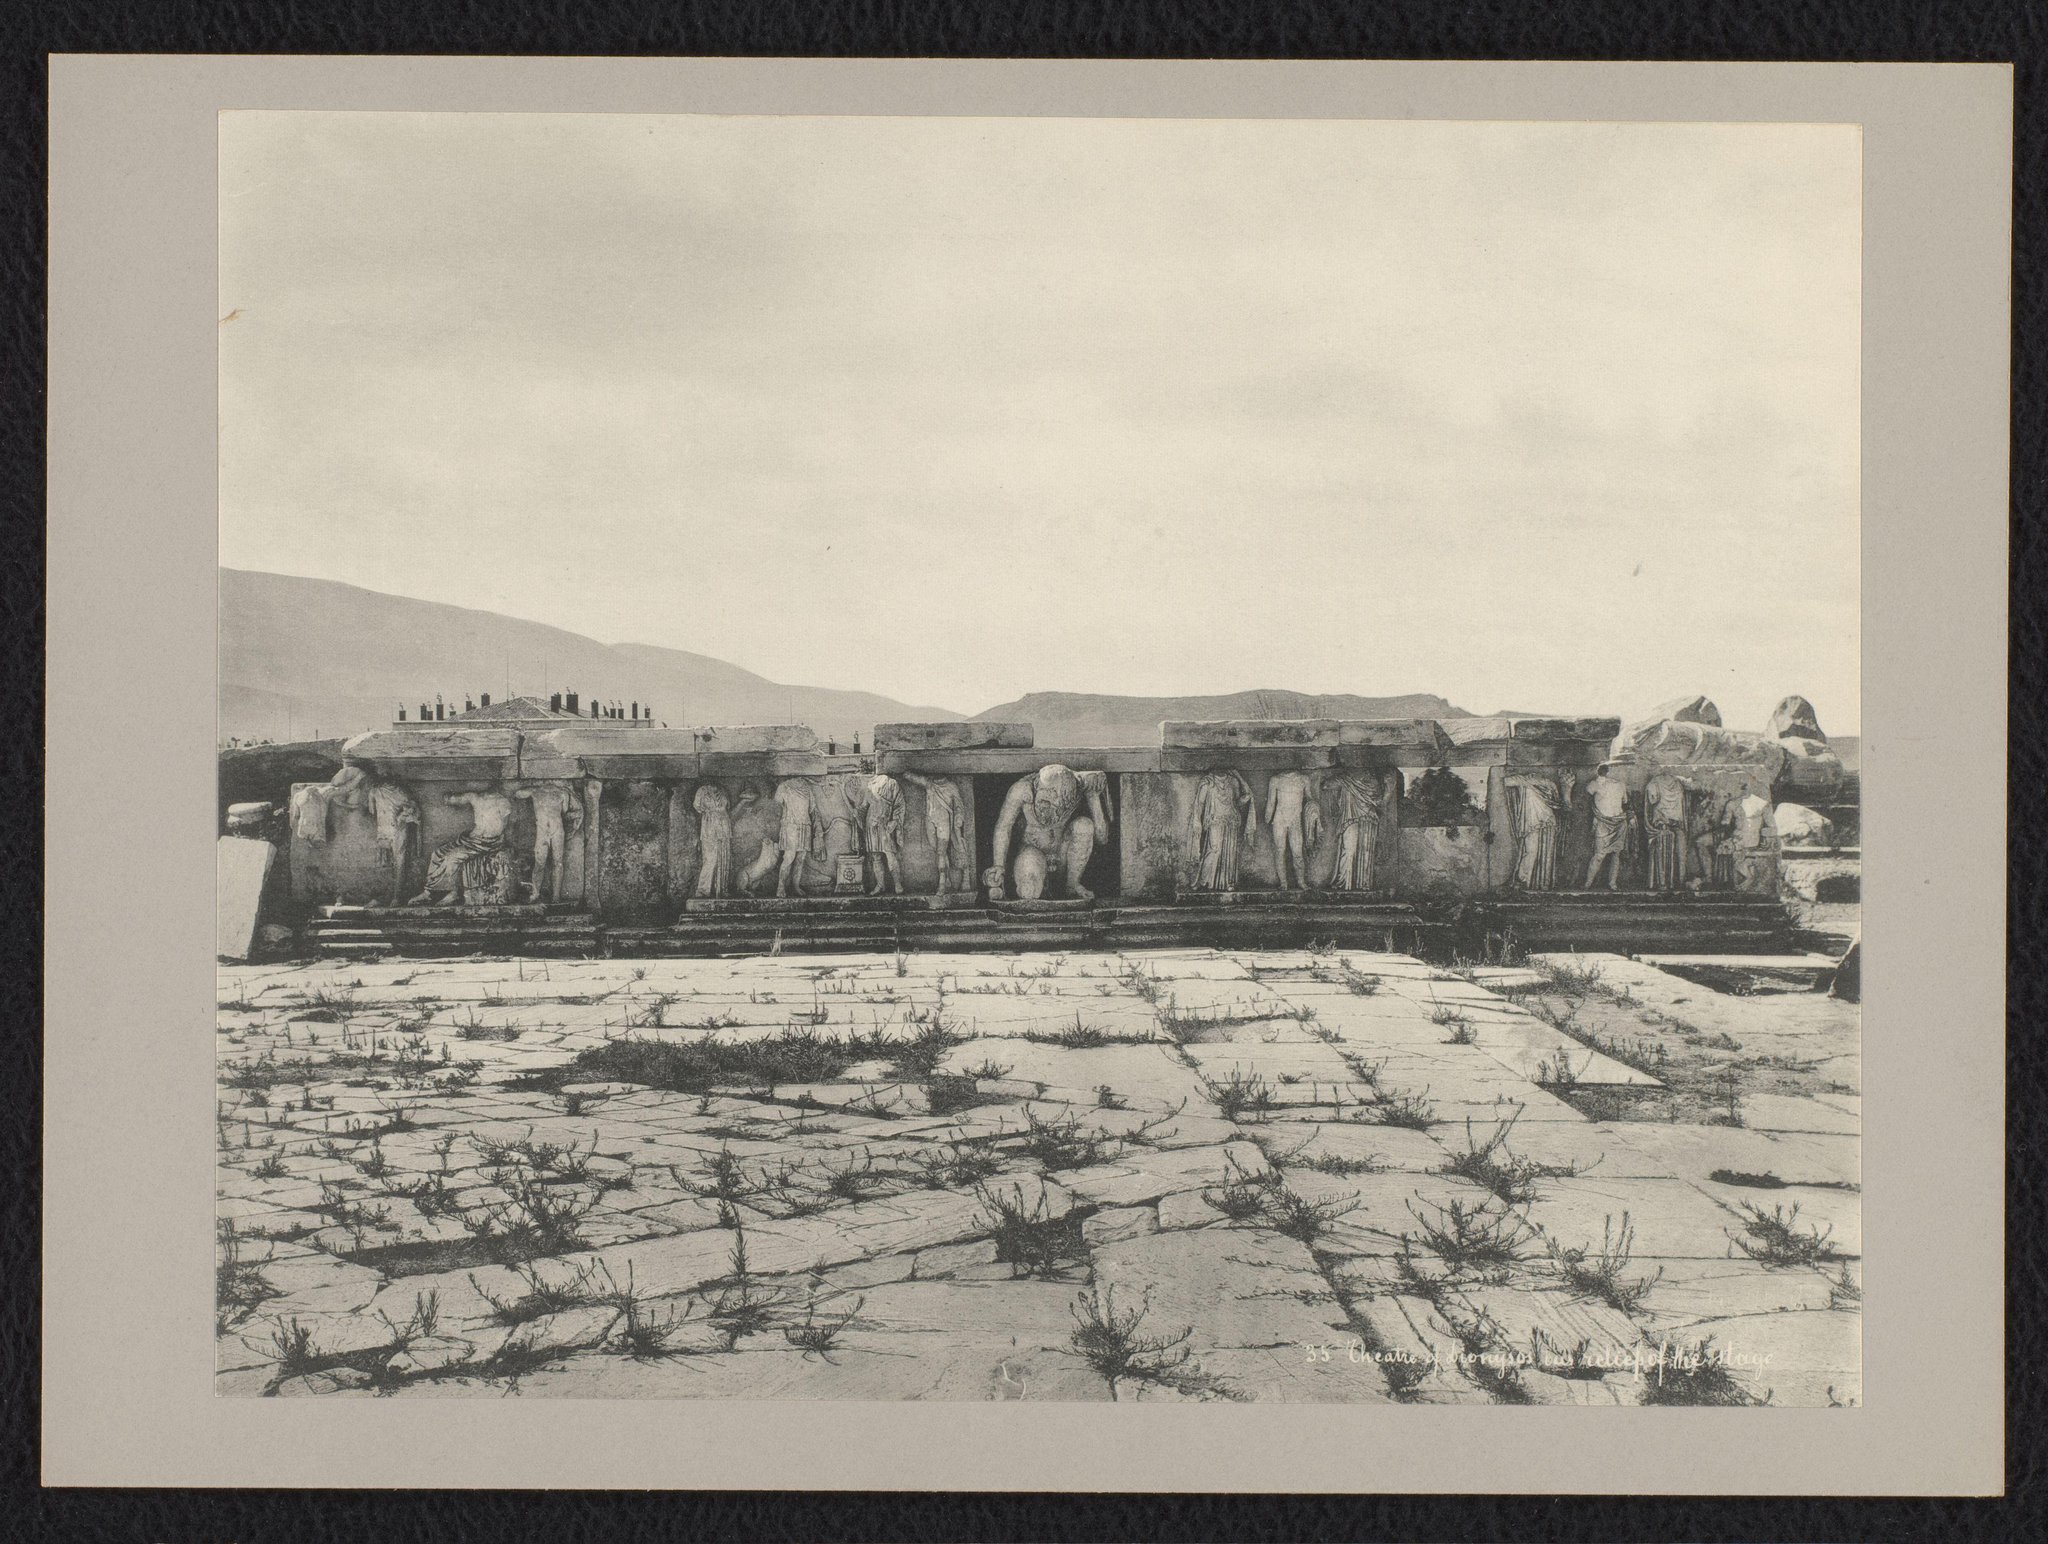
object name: photograph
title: Reliëfs bij het Theater van Bacchus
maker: Anonymous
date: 1895-1915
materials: cardboard, paper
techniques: photograph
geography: athens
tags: athene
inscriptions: annotation: ‘28. Theater van Bachus.’